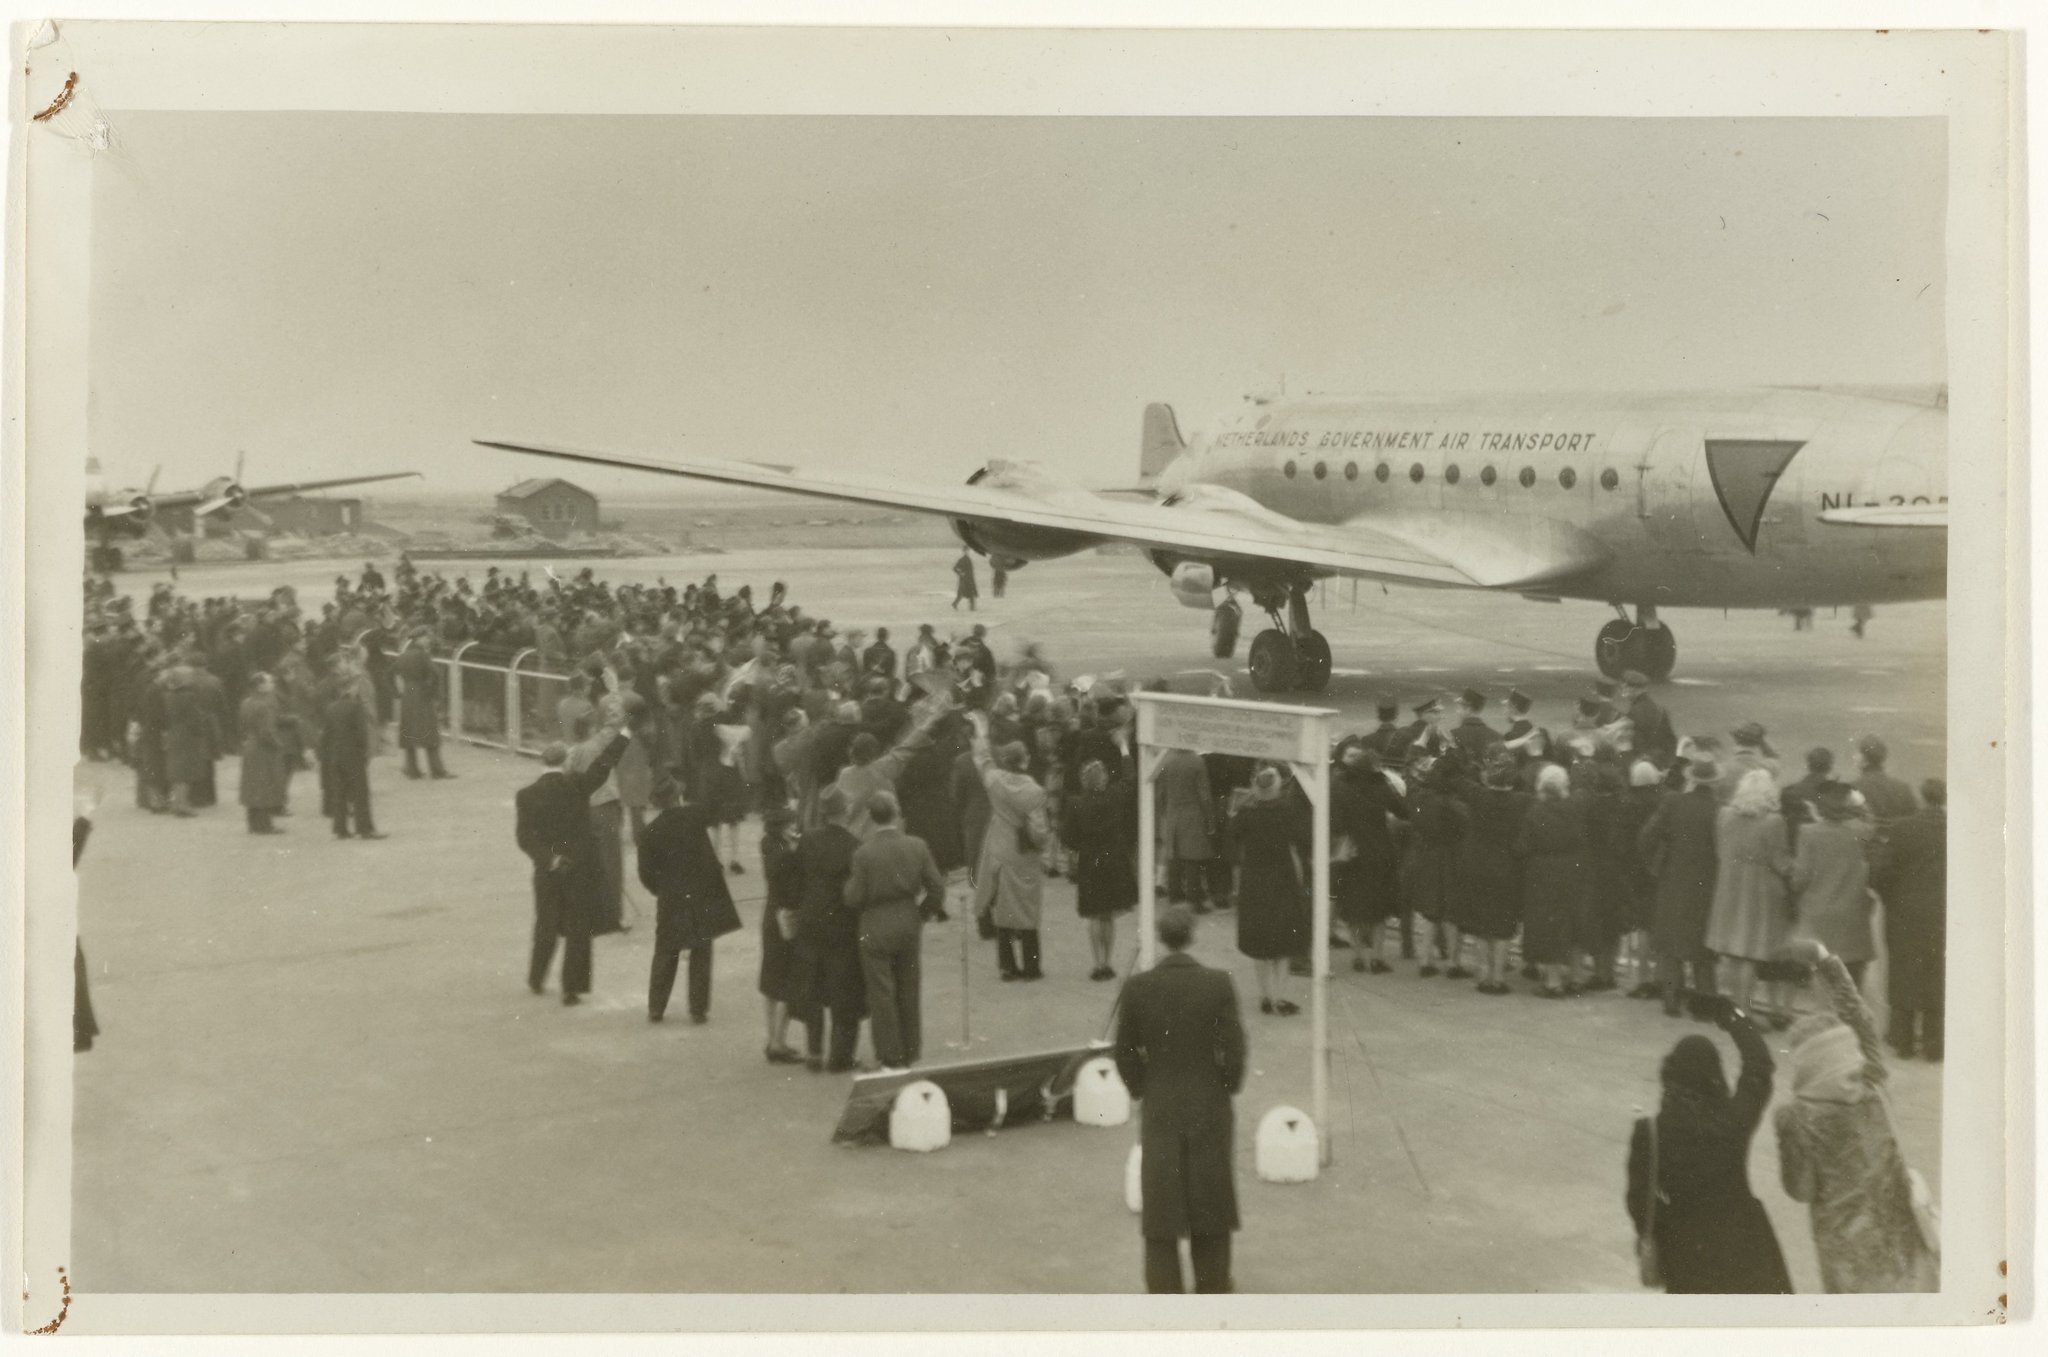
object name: photograph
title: Vertrek van het eerste vliegtuig van de lijn Amsterdam-Curaçao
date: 1946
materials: photographic support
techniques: photography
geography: schiphol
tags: amsterdam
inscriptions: stamp: ‘COPYRIGHT / 'ANEFO' / ALGEMEEN NEDERLANDSCH FOTOBUREAU’, inscription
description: Het vertrek van het eerste vliegtuig van de lijn Amsterdam-Curaçao.Gezagvoerder was A. Viruly. Opening van de luchtlijn Amsterdam Curacao door de Regeringsluchtvaartdienst.